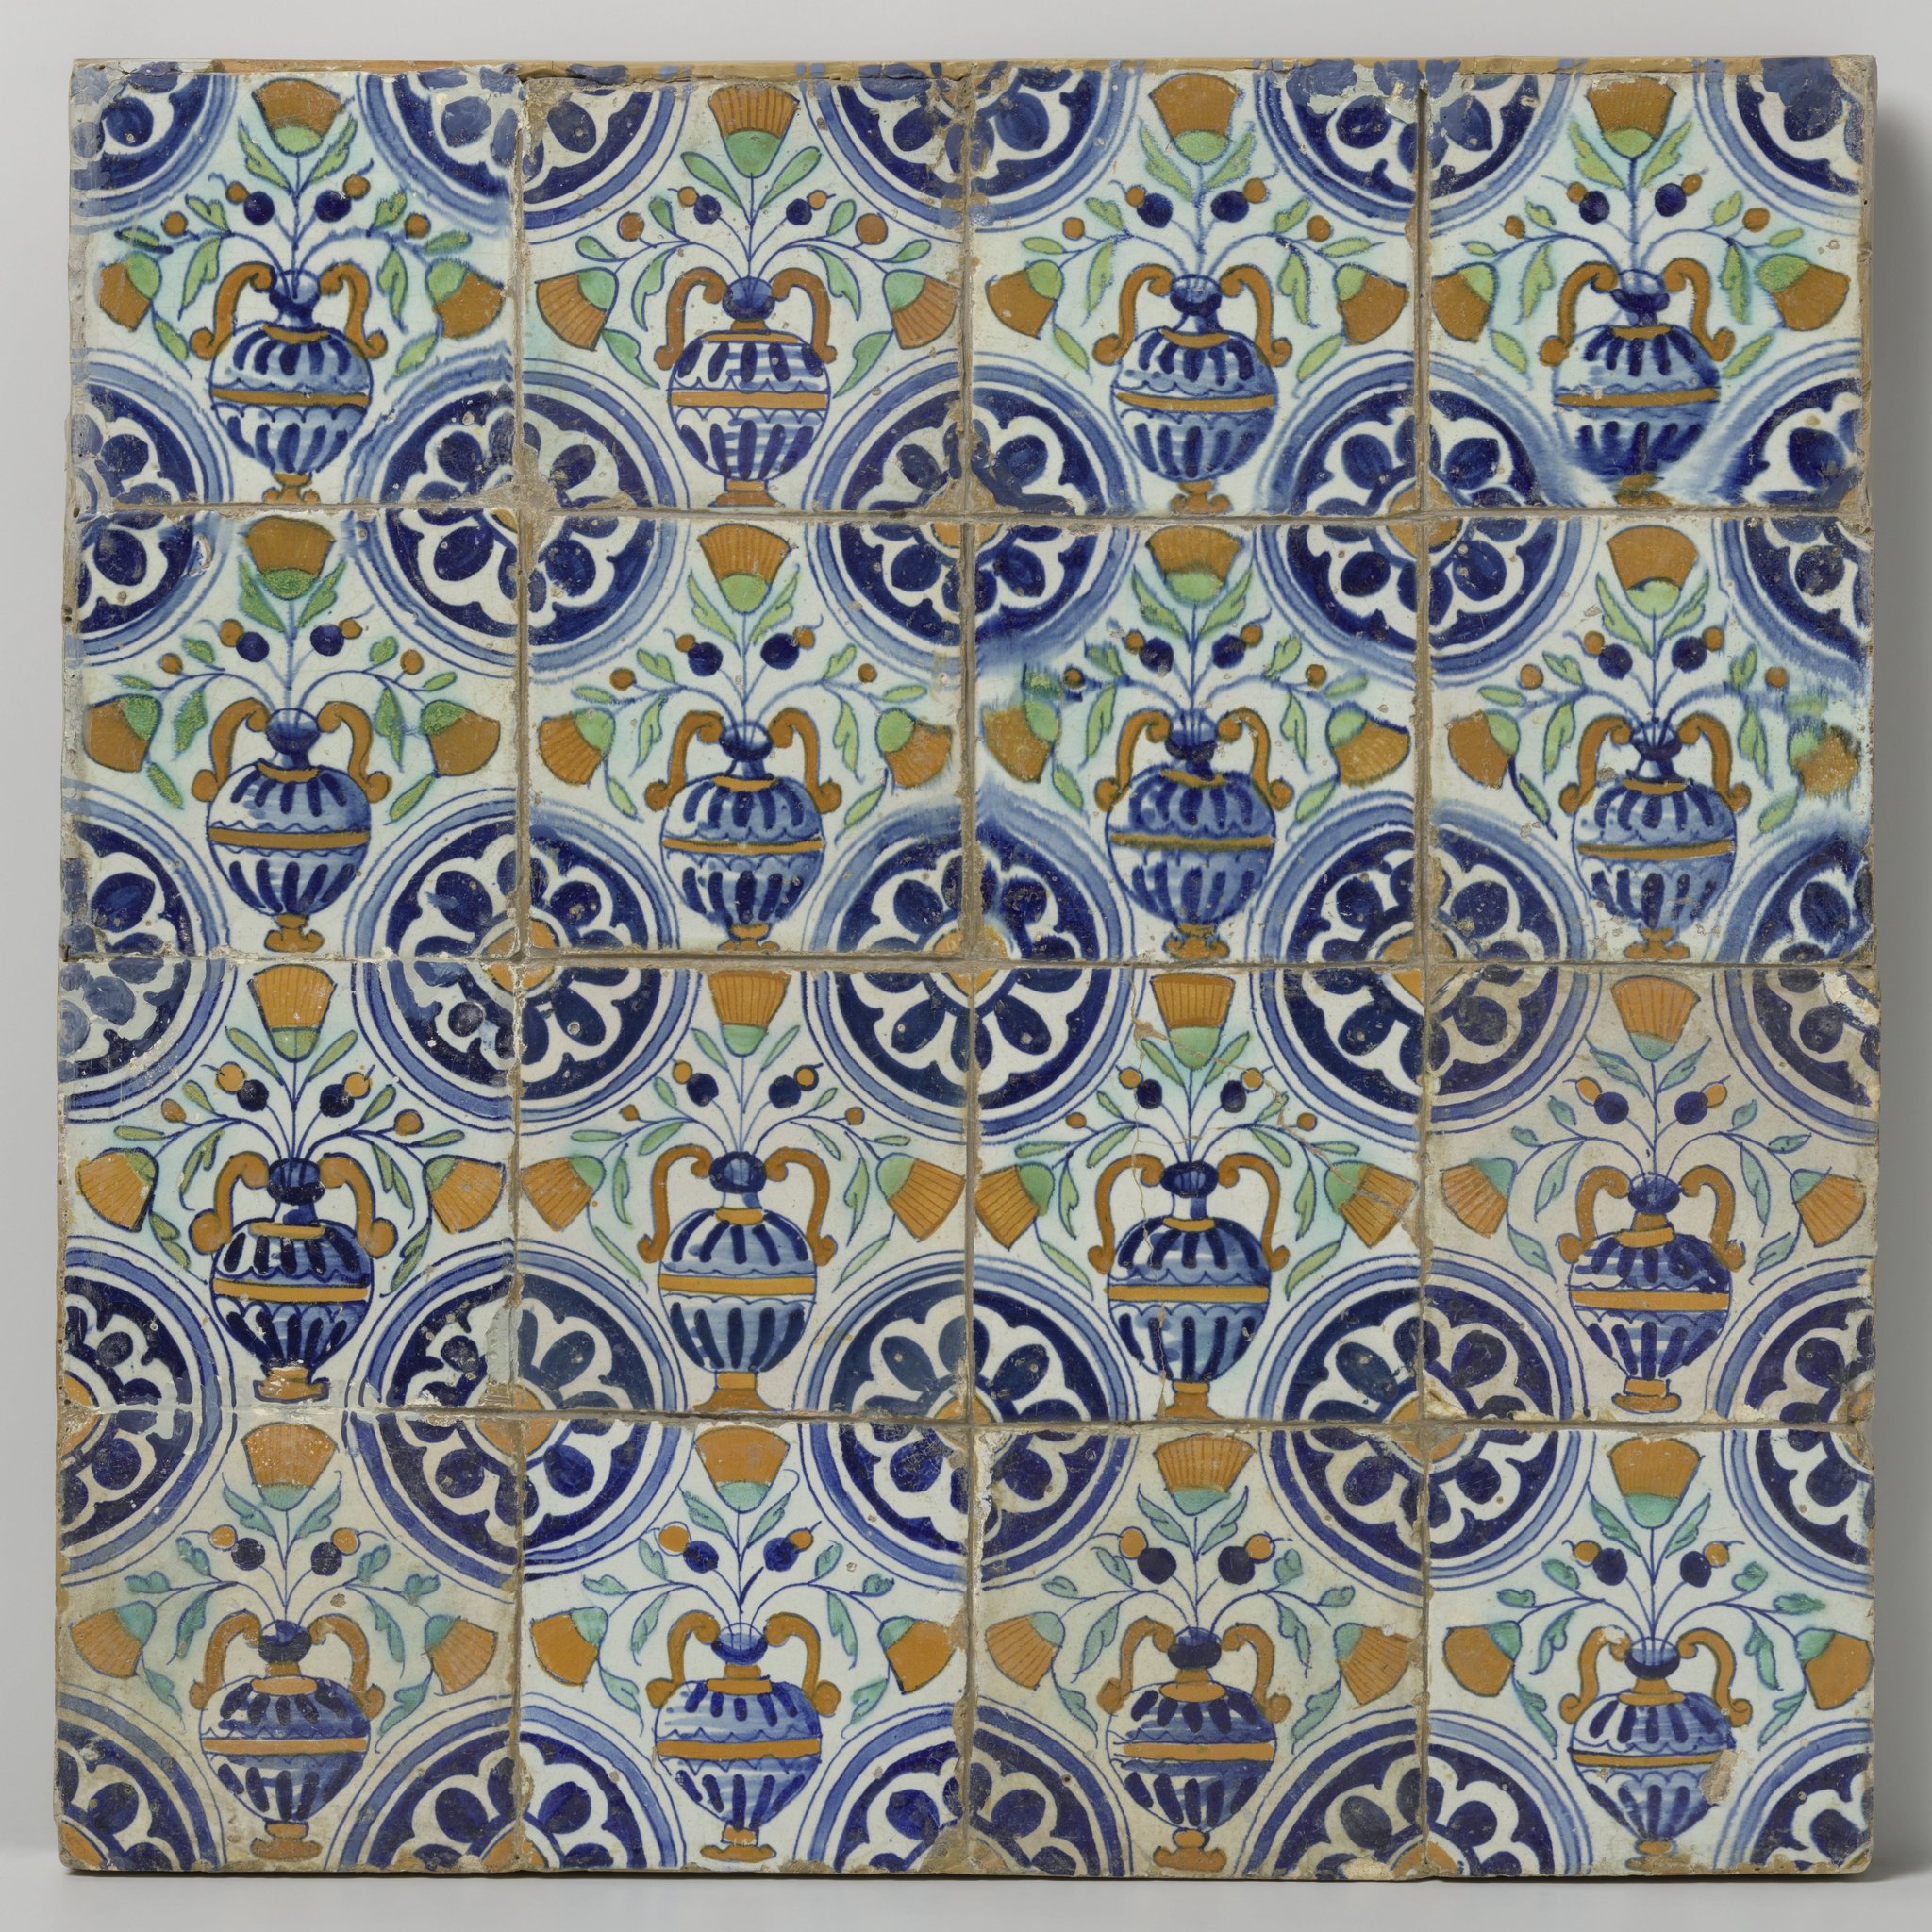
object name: tegelveld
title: Veld van zestien tegels met bloempotten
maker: Anonymous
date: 1610-1625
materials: earthenware, glaze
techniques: maiolica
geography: netherlands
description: Veld van zestien tegels (4 x 4) elk met een veelkleurige (blauw, oranje, groen en geel) bloempot met goudsbloemen. In de hoeken, een kwart rozet.